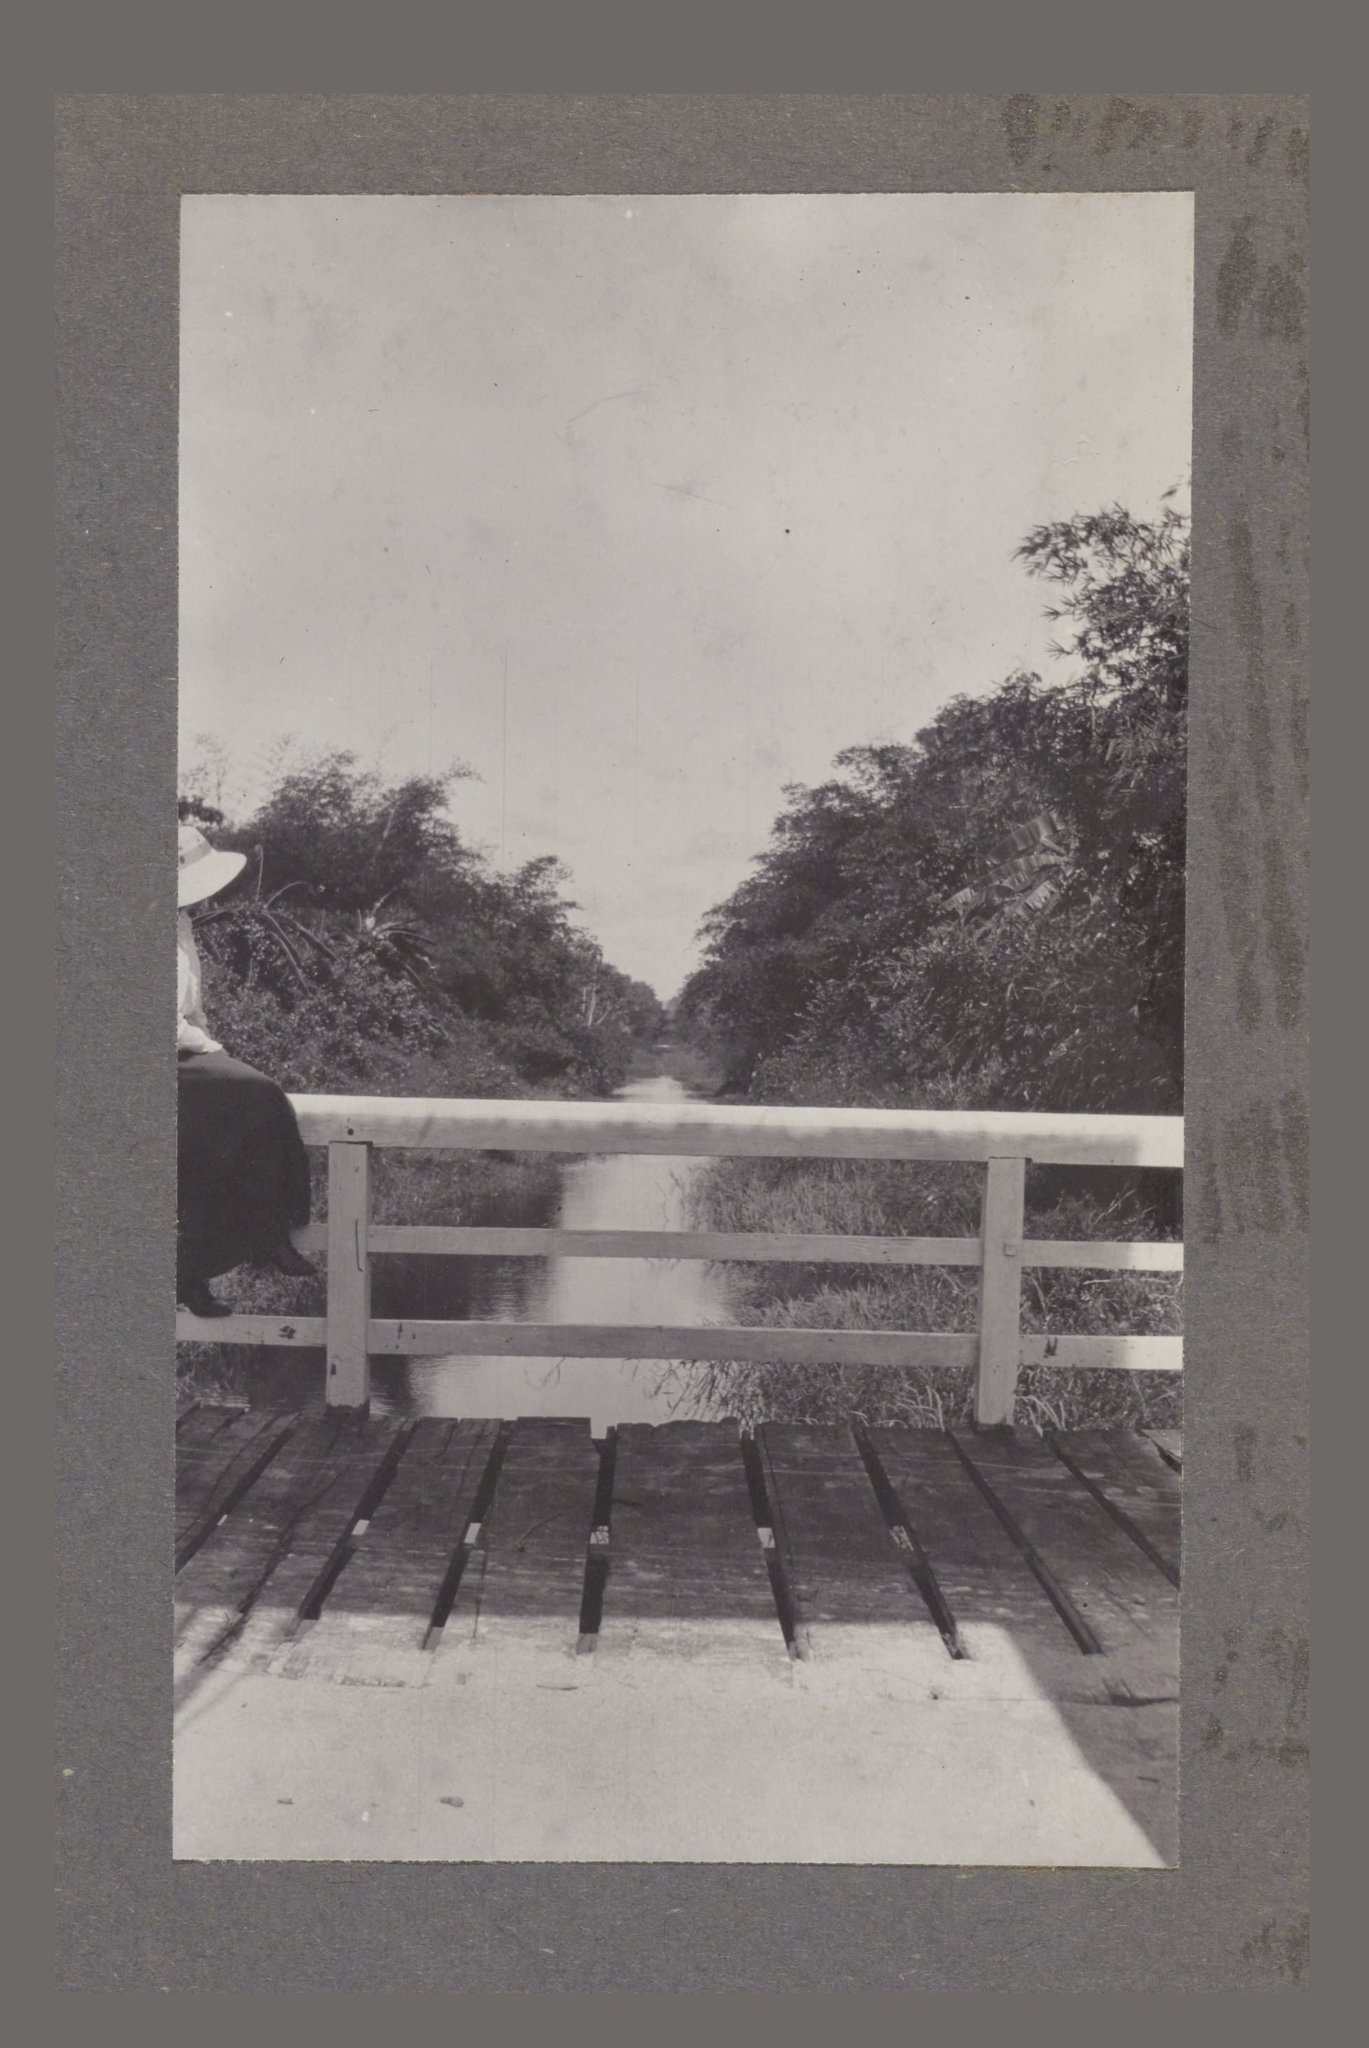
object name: photograph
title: Maria Gonggrijp op een brug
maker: andries augustus boom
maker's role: amateurfotograaf, handelaar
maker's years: 1878-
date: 1911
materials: photographic support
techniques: photography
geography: suriname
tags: suriname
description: Maria Gonggrijp zittend op een houten brugleuning, waarschijnlijk onderweg naar Plantage Morgenstond, 1911. Onderdeel van het fotoalbum over het leven van de familie Gonggrijp in Suriname rond 1912.